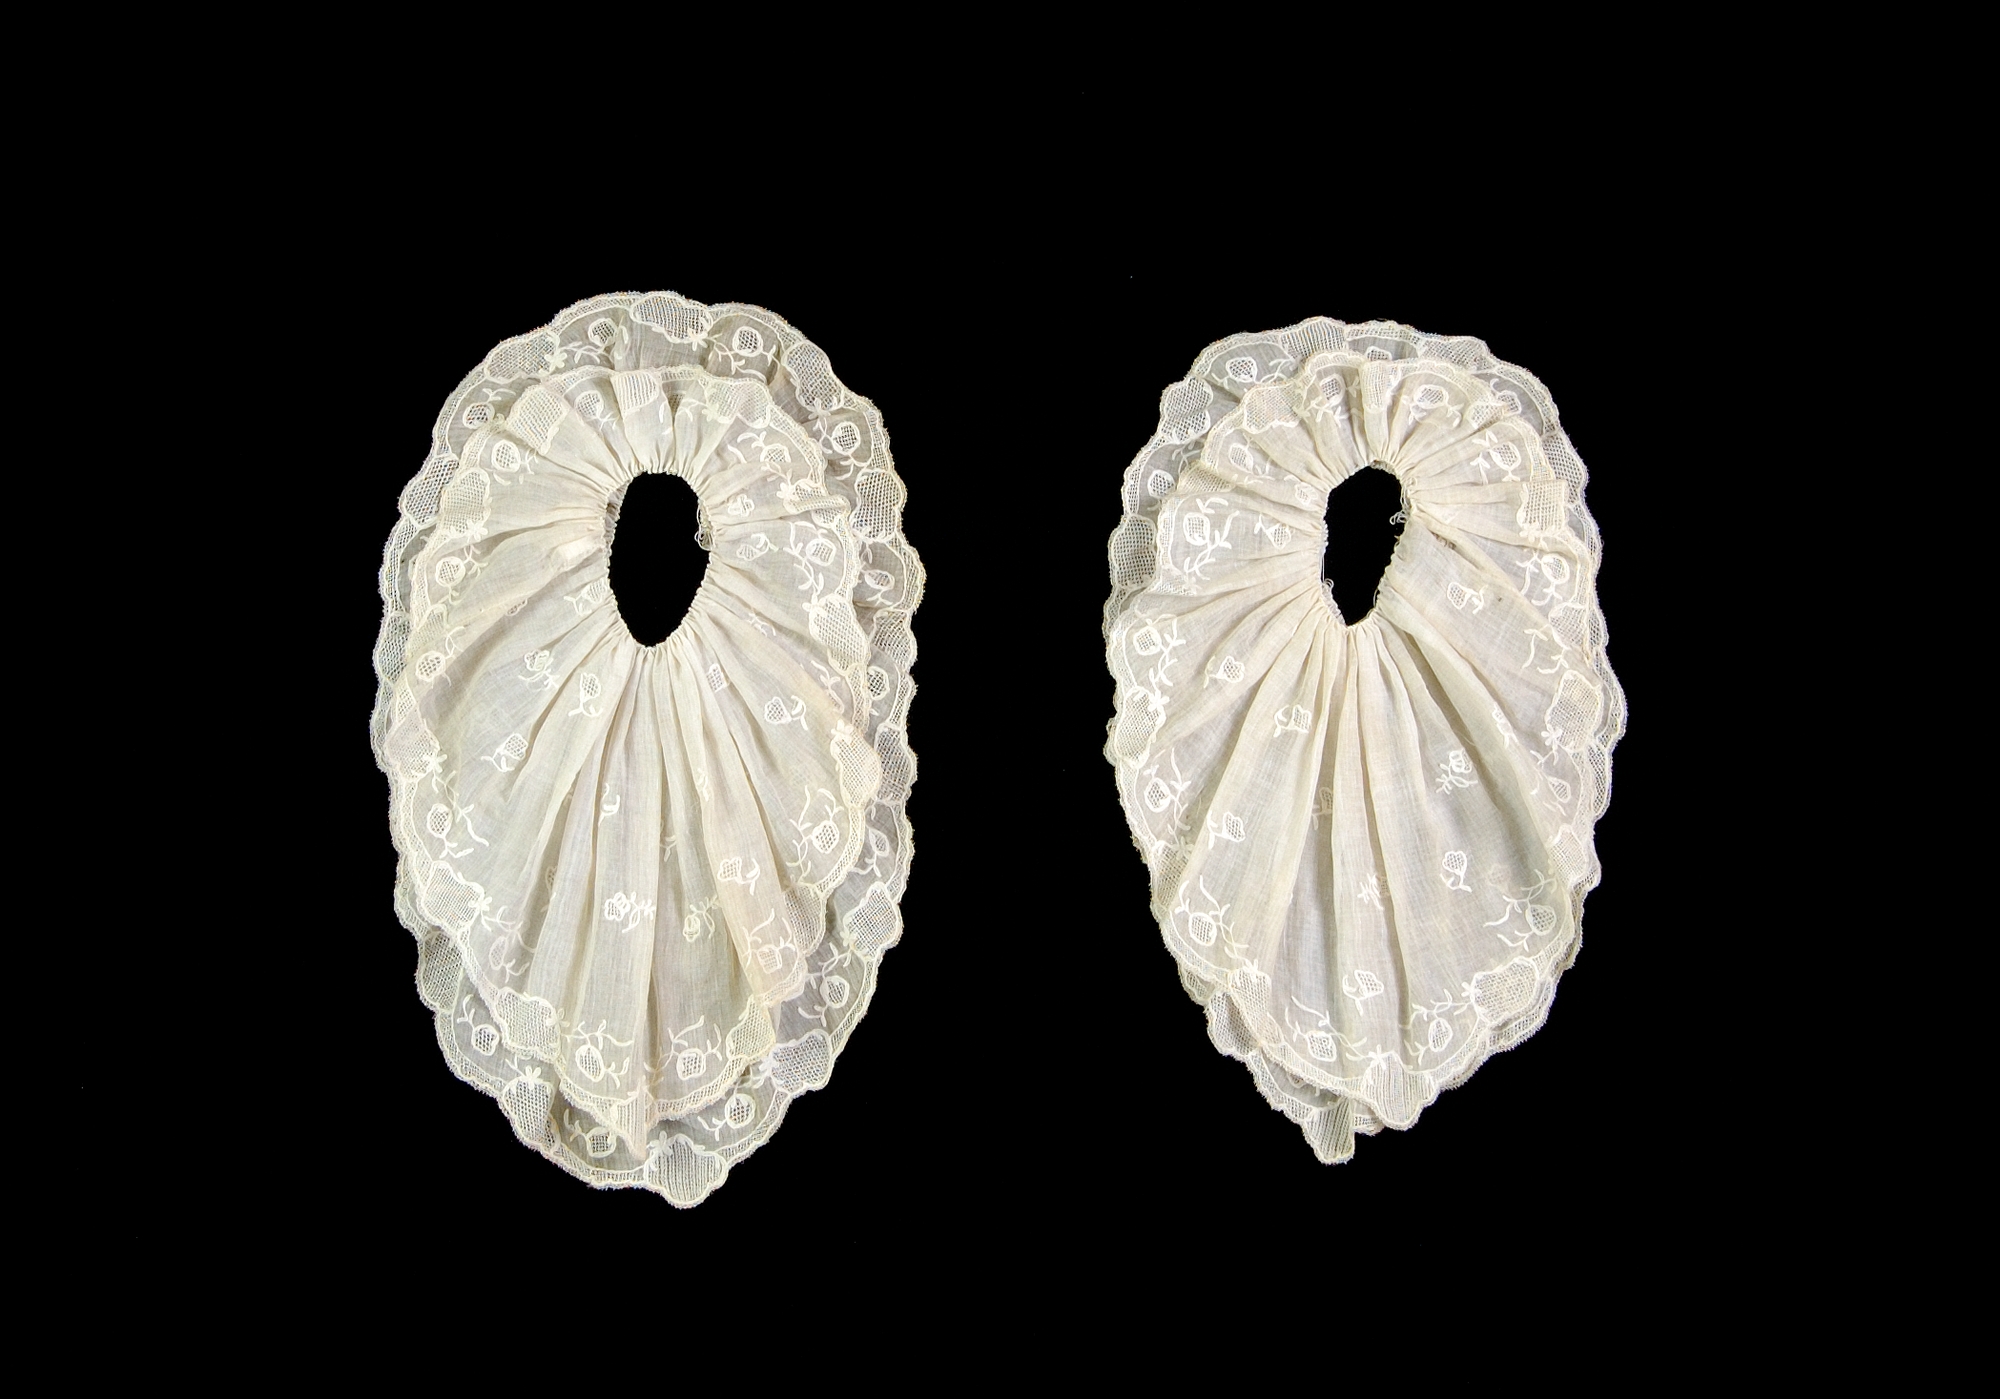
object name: engageantes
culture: british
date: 1760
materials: cotton